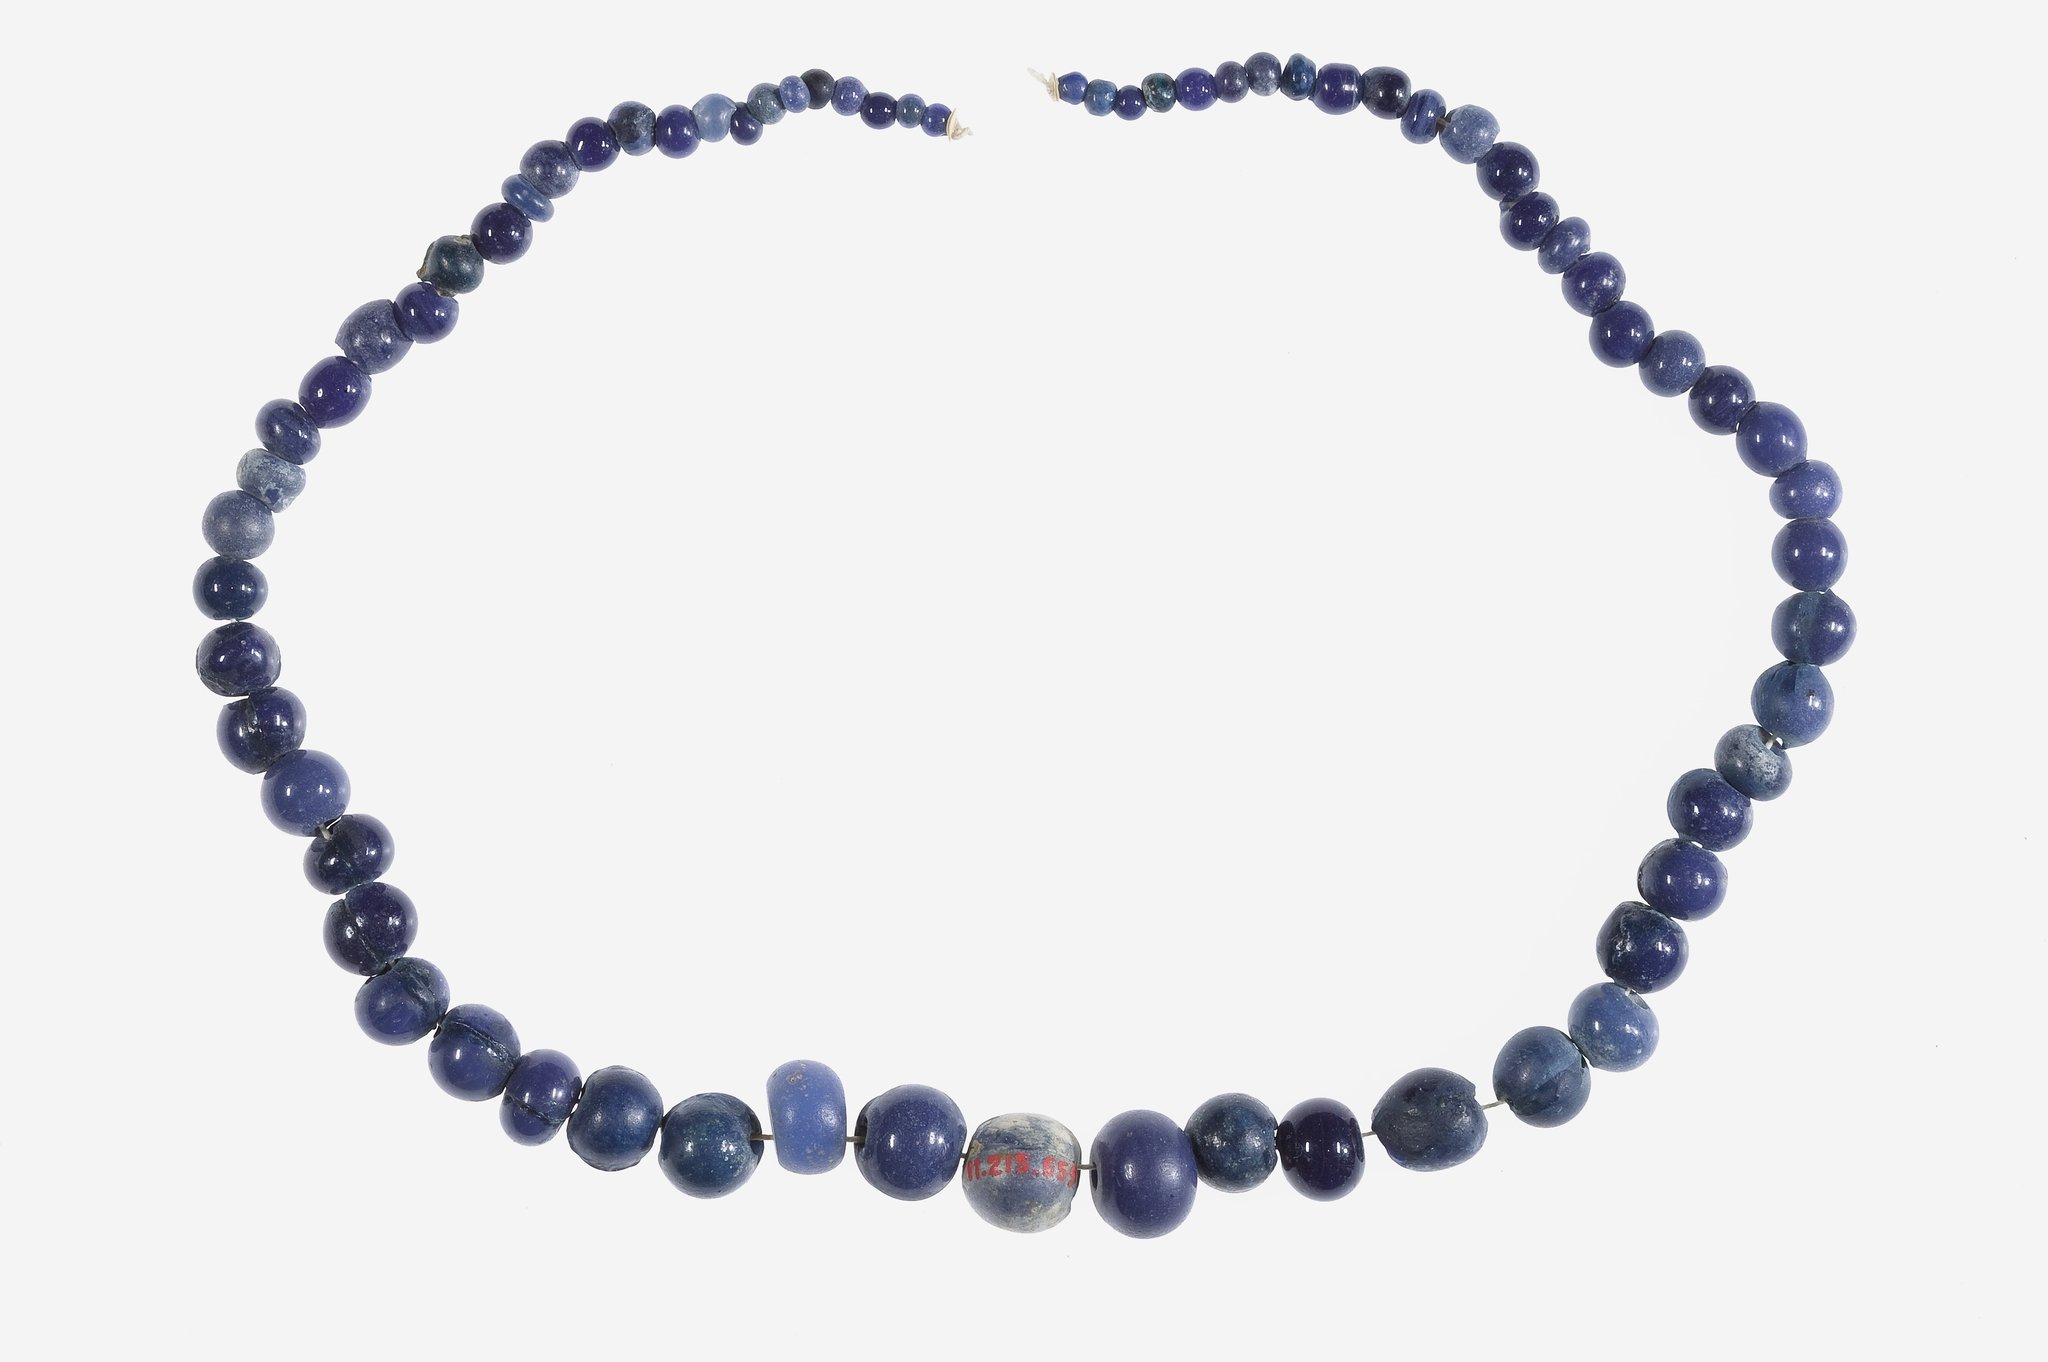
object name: bead, string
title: String of Ball Beads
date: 1390-1352 BCE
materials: glass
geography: egypt